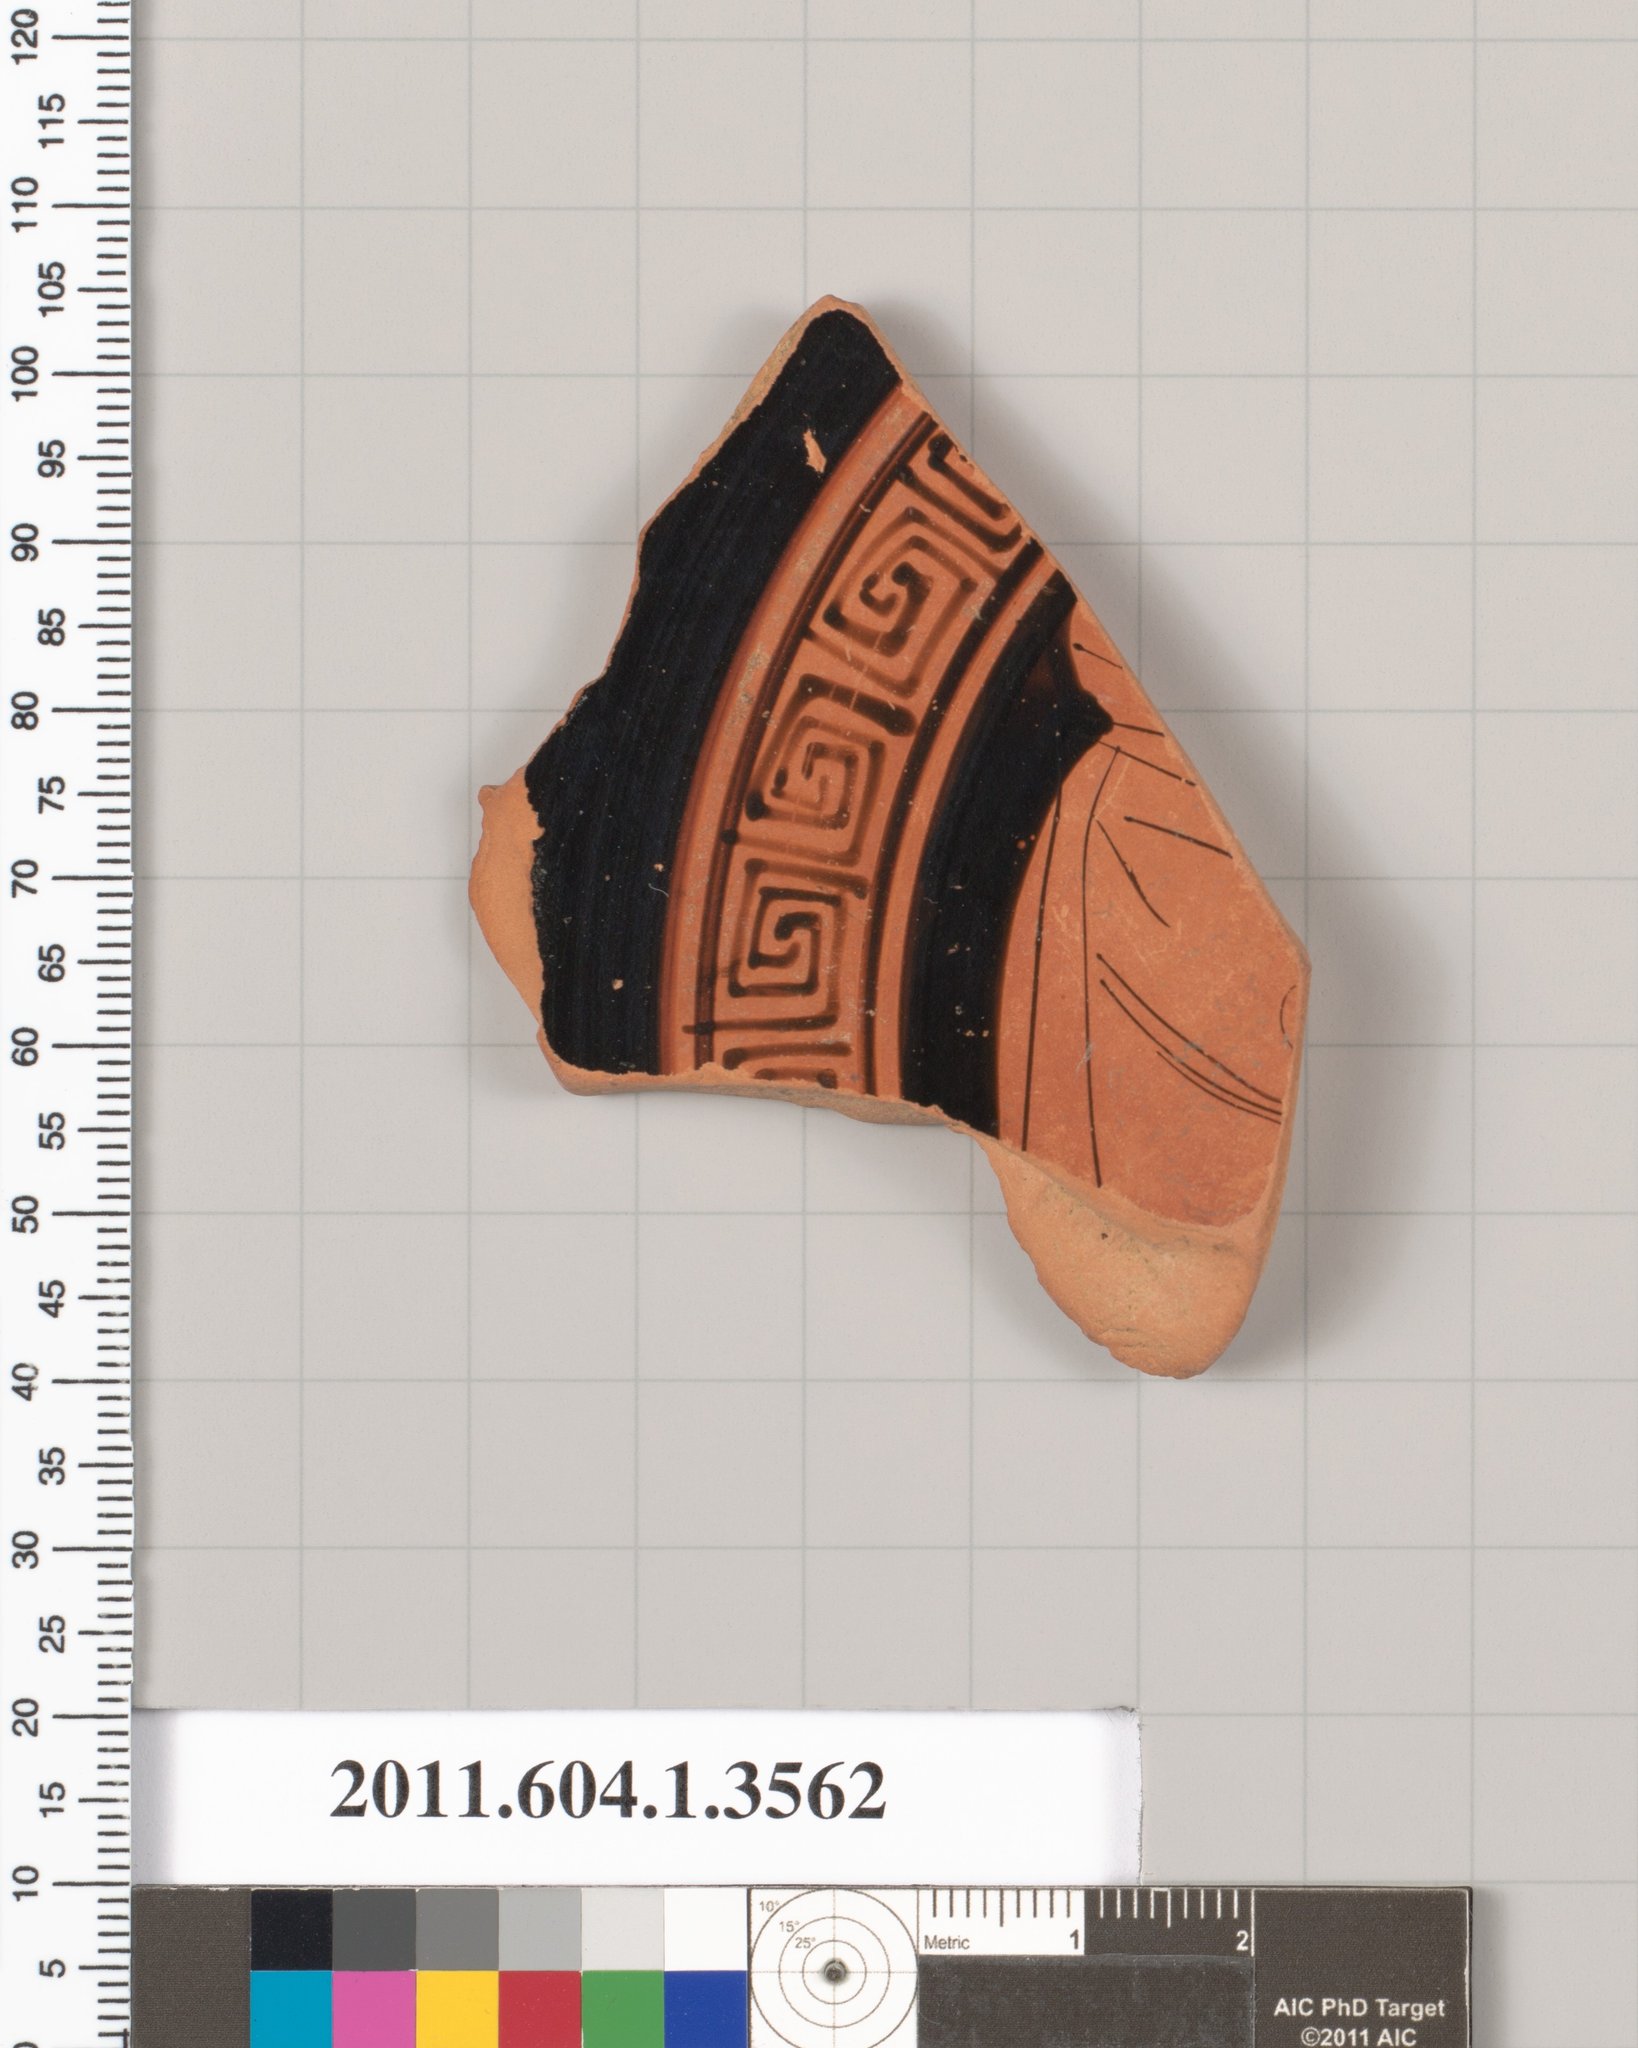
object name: kylix fragment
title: Terracotta fragment of a kylix (drinking cup)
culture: greek, attic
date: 475-451 BCE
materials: terracotta